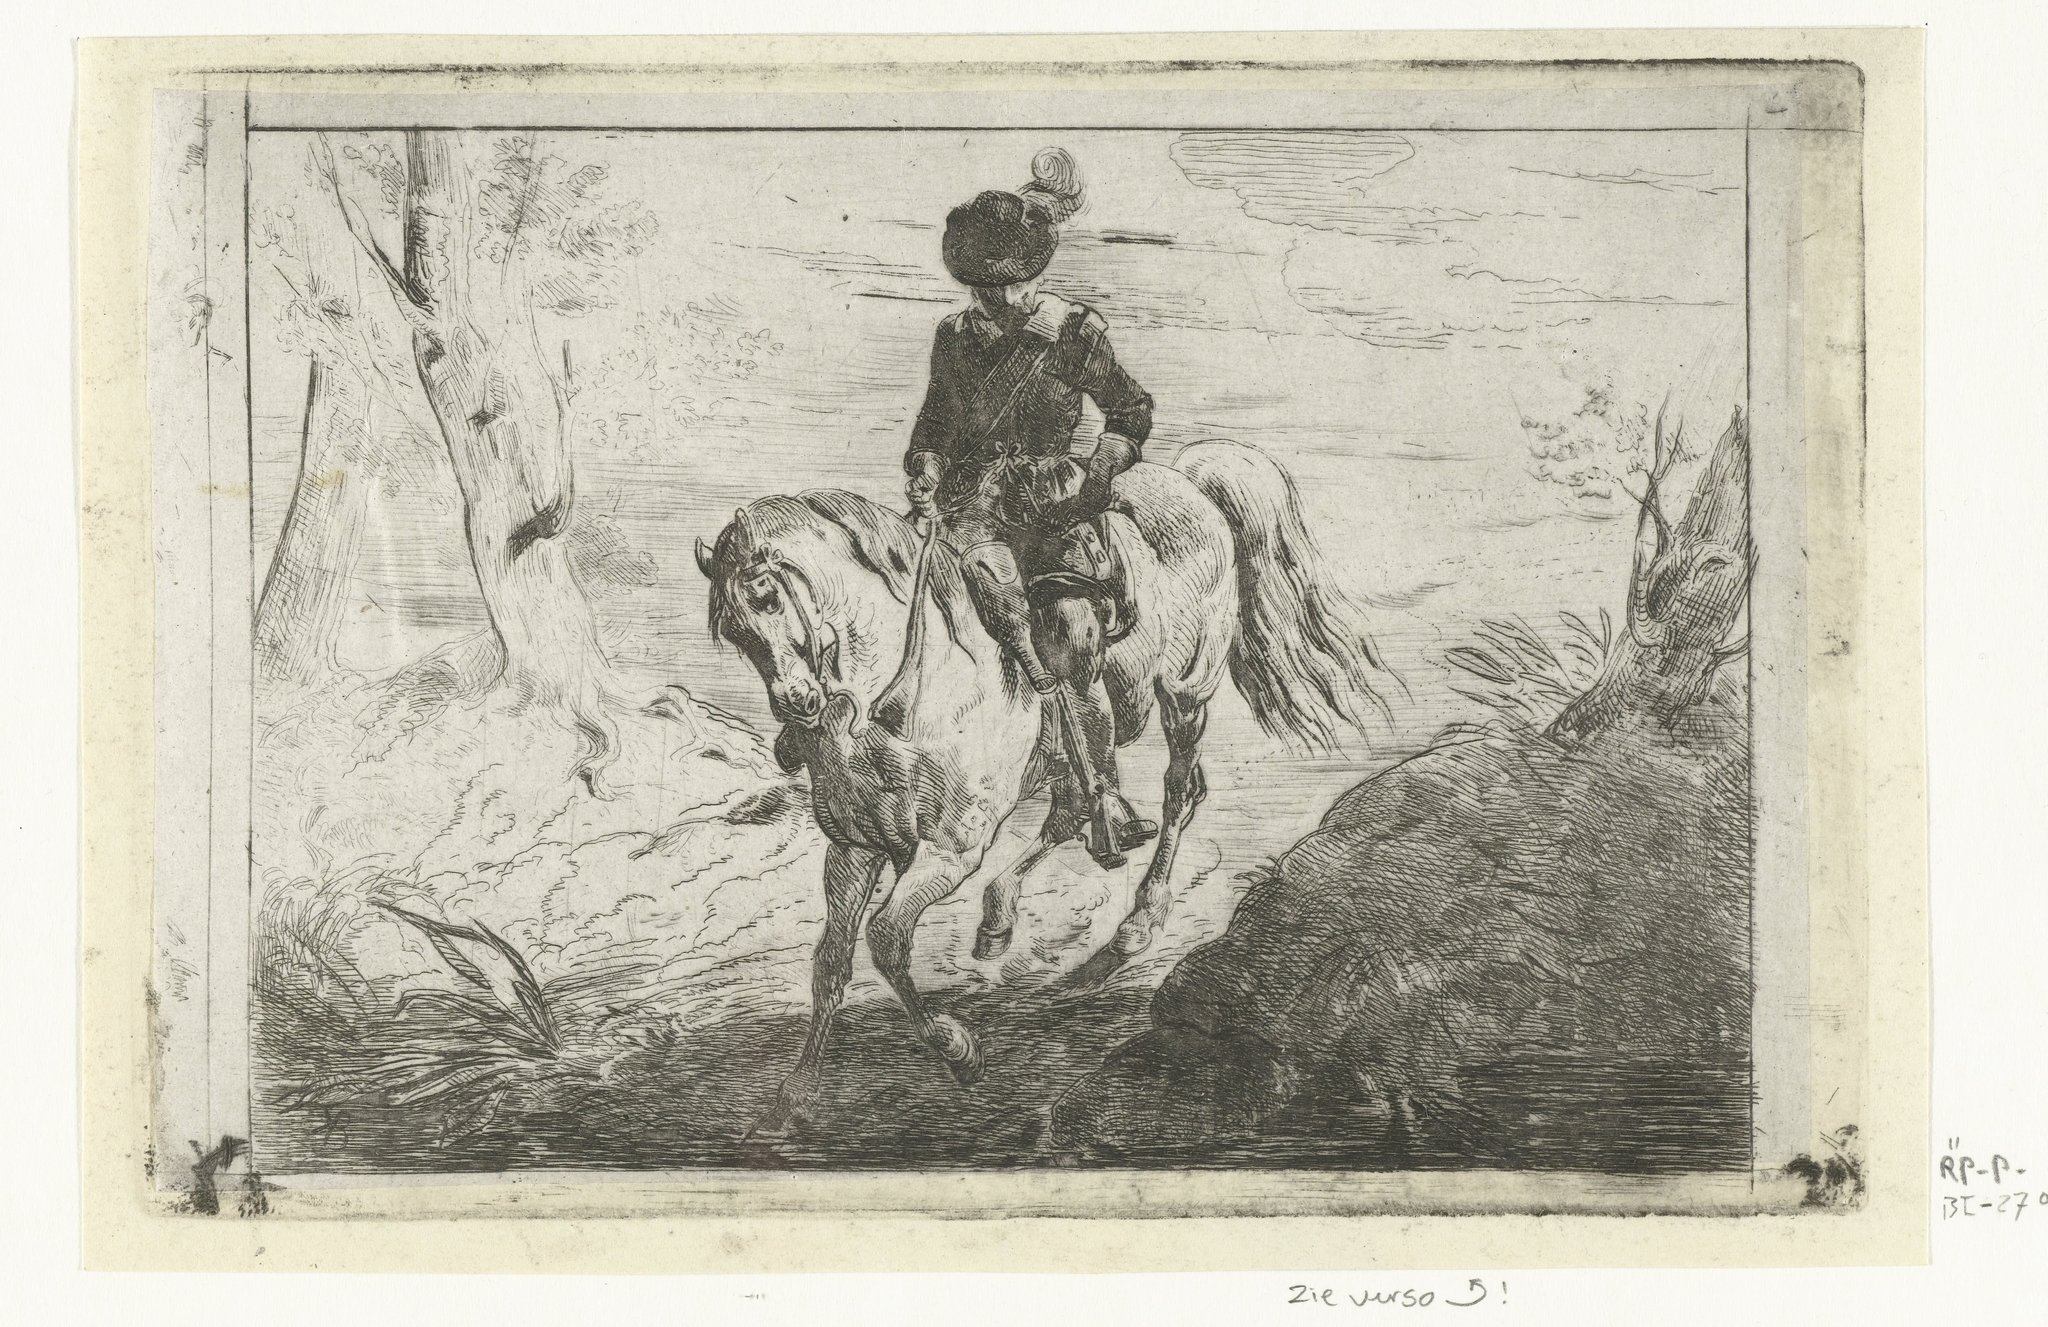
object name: print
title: Ruiter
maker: karel frederik bombled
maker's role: draughtsman, print maker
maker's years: 1822-1902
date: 1832-1902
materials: paper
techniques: drypoint, etching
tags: riding a horse, ass, or mule; rider, horseman, forest path or lane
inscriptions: collector's mark: Lugt 2228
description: Een man te paard rijdt over een weg in het bos. Op het verso staat een fragment van een figuurstudie van een naakte vrouw met appel.